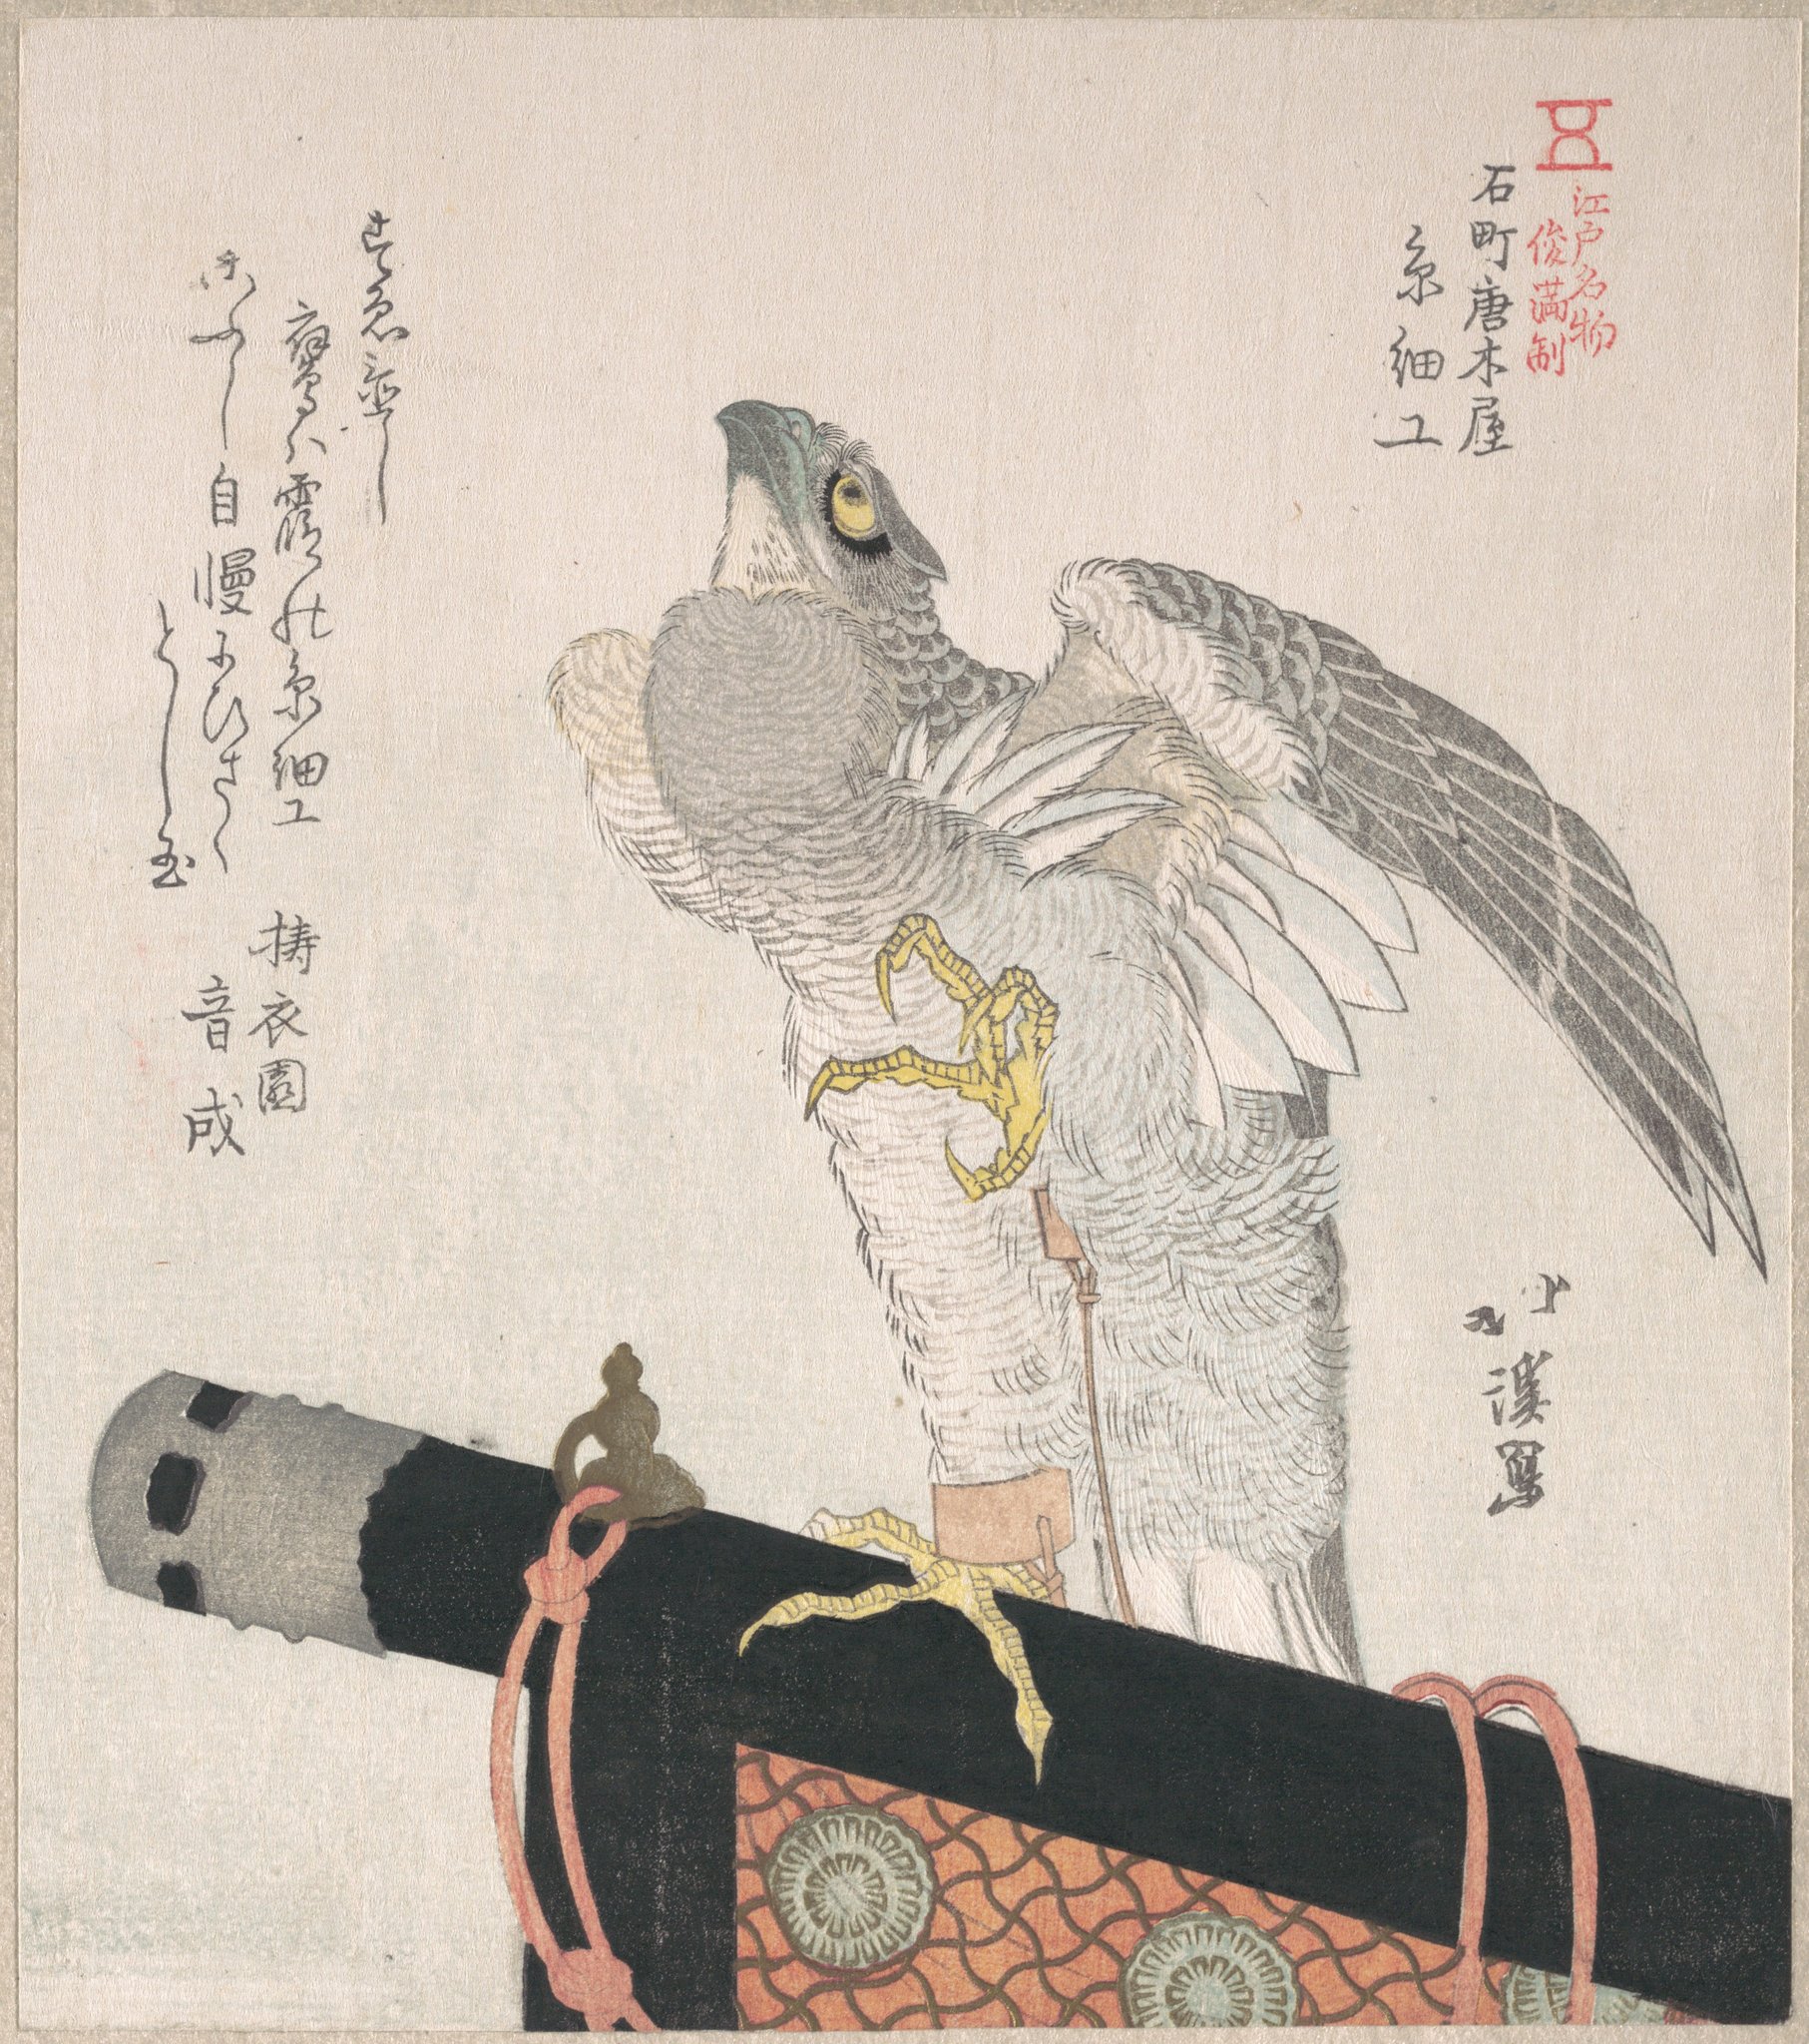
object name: album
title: Hawk Made of Silk; Specialities of Karakiya in Kokucho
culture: japanese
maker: totoya hokkei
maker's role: artist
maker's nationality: japanese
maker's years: 1780-1850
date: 1801-1900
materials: ink, paper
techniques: surimono, woodblock print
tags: hawks